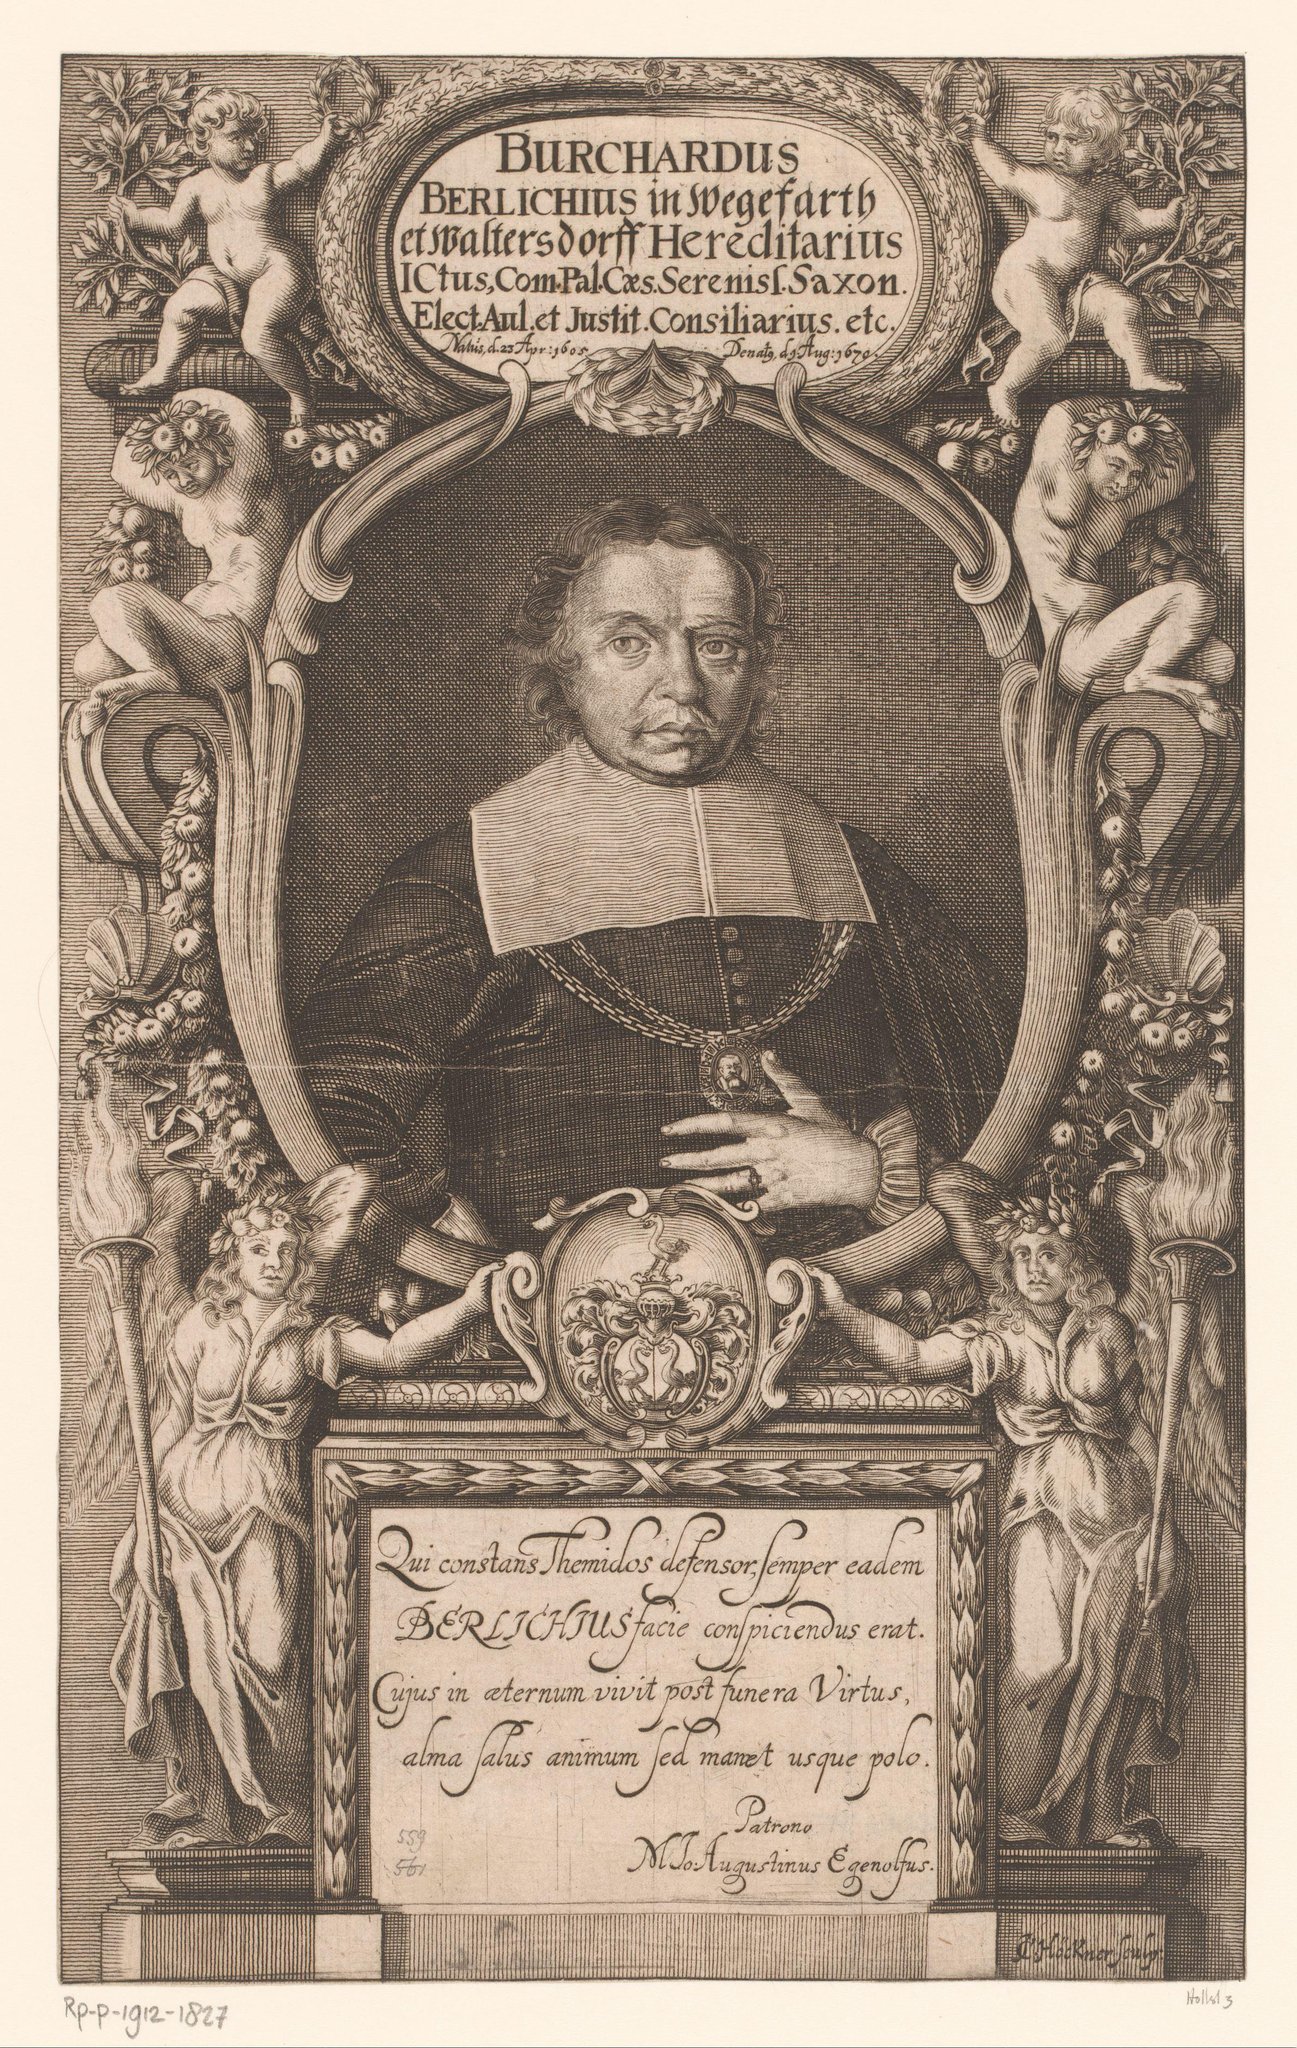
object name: print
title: Portret van Burchard Berlich in decoratieve omlijsting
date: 1670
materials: paper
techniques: engraving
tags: burchard berlich, trees: laurel (branch, stick), trees: palm-tree (+ branch, stick), historical persons, pendant, trinket, 'breloque', ornament ~ festoon, garland, cupids: 'amores', 'amoretti', 'putti', armorial bearing, heraldry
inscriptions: collector's mark: Lugt 2228